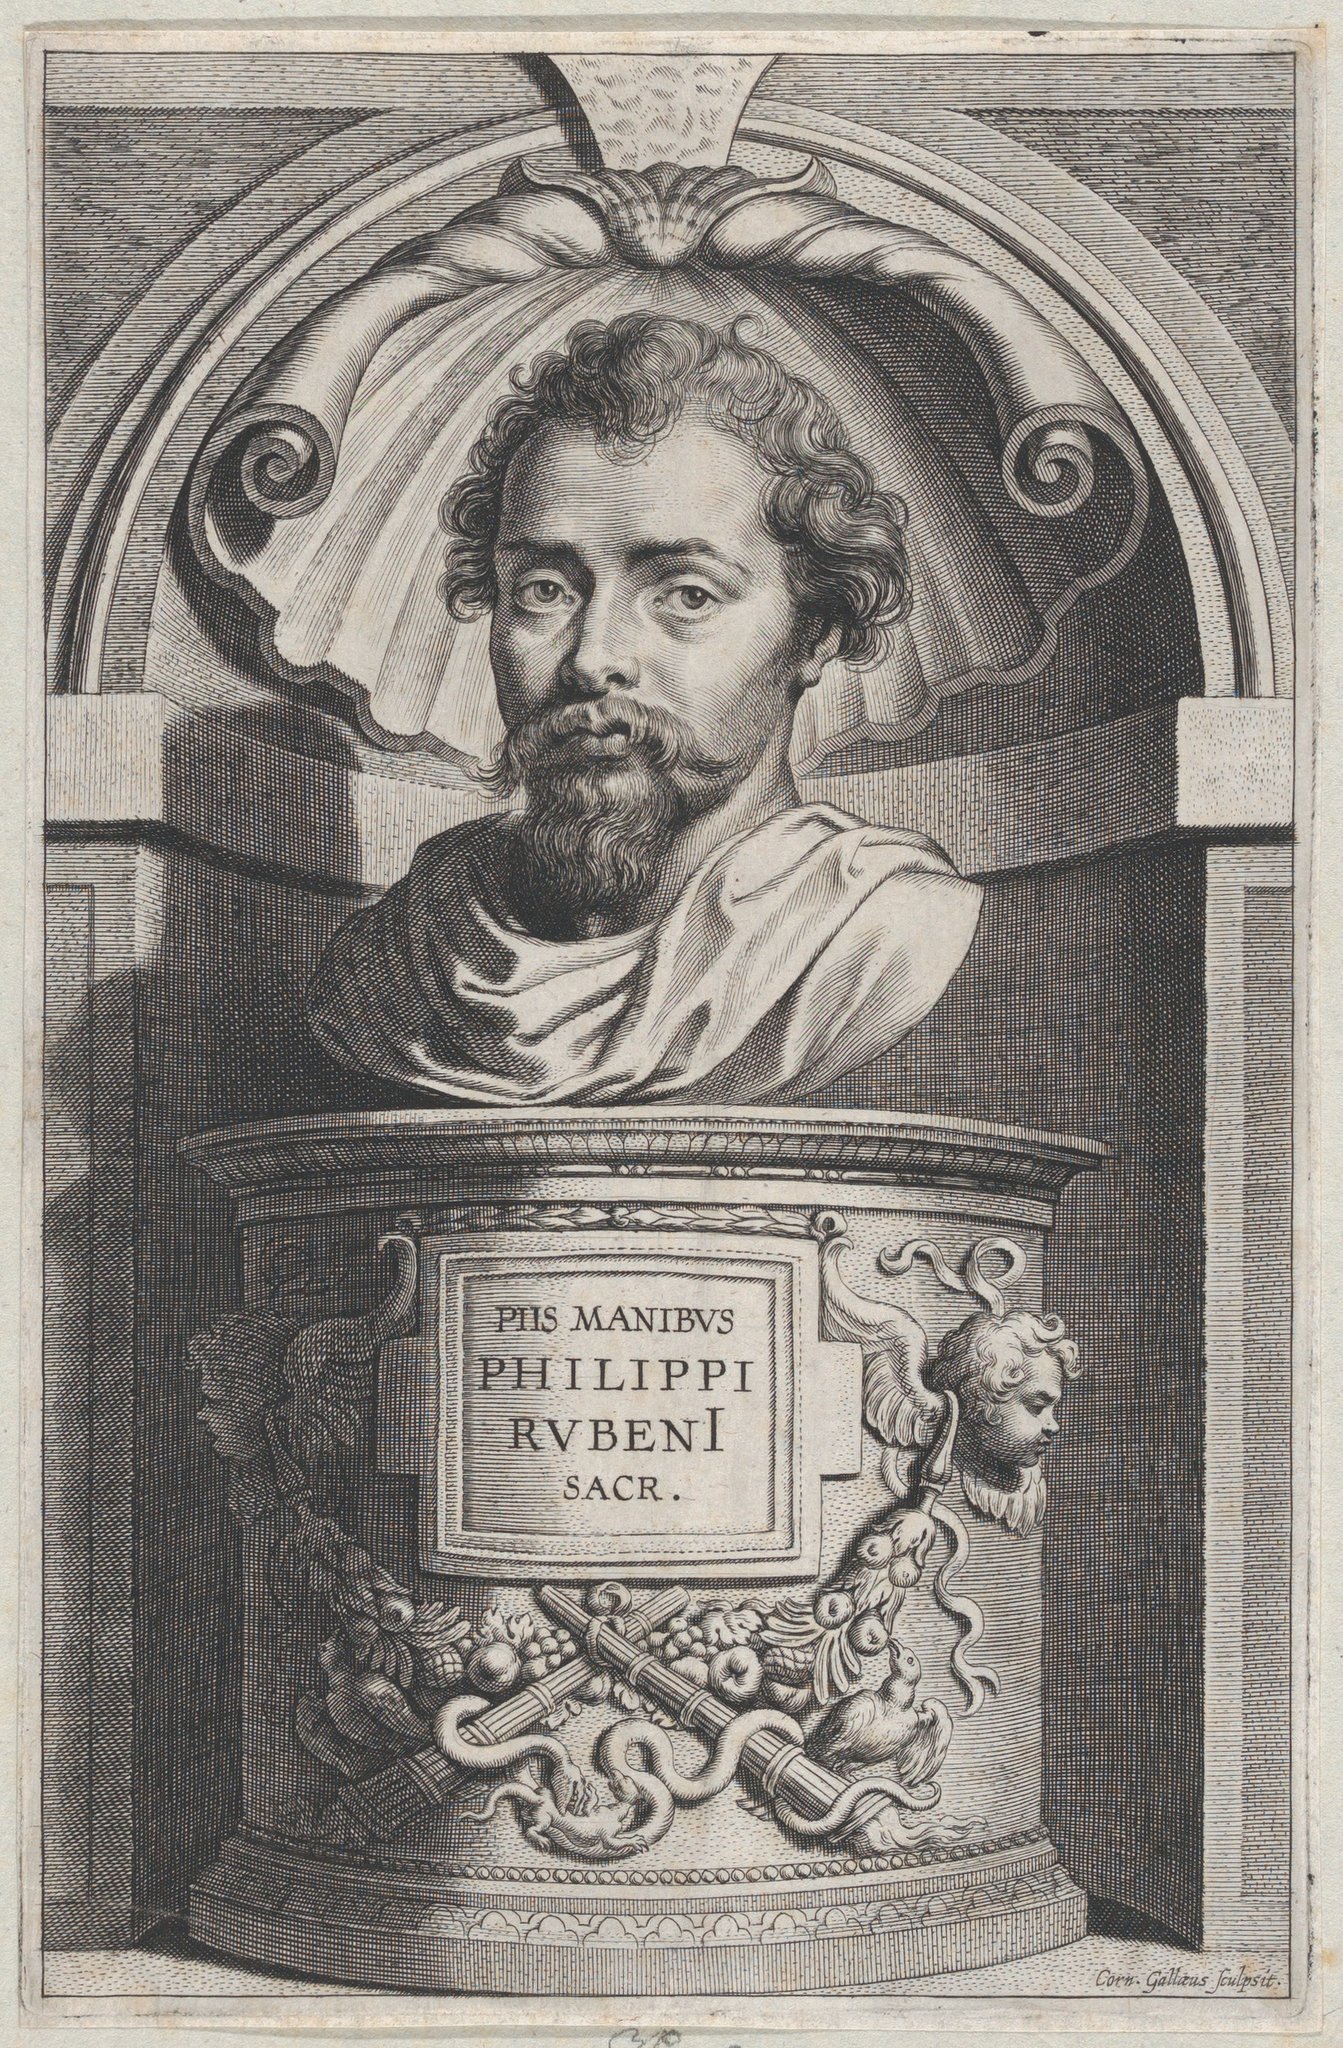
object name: print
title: Bust portrait of Philip Rubens, in a niche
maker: cornelis galle (ii)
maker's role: artist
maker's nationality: flemish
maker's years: 1615-1678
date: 1627-1678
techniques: engraving